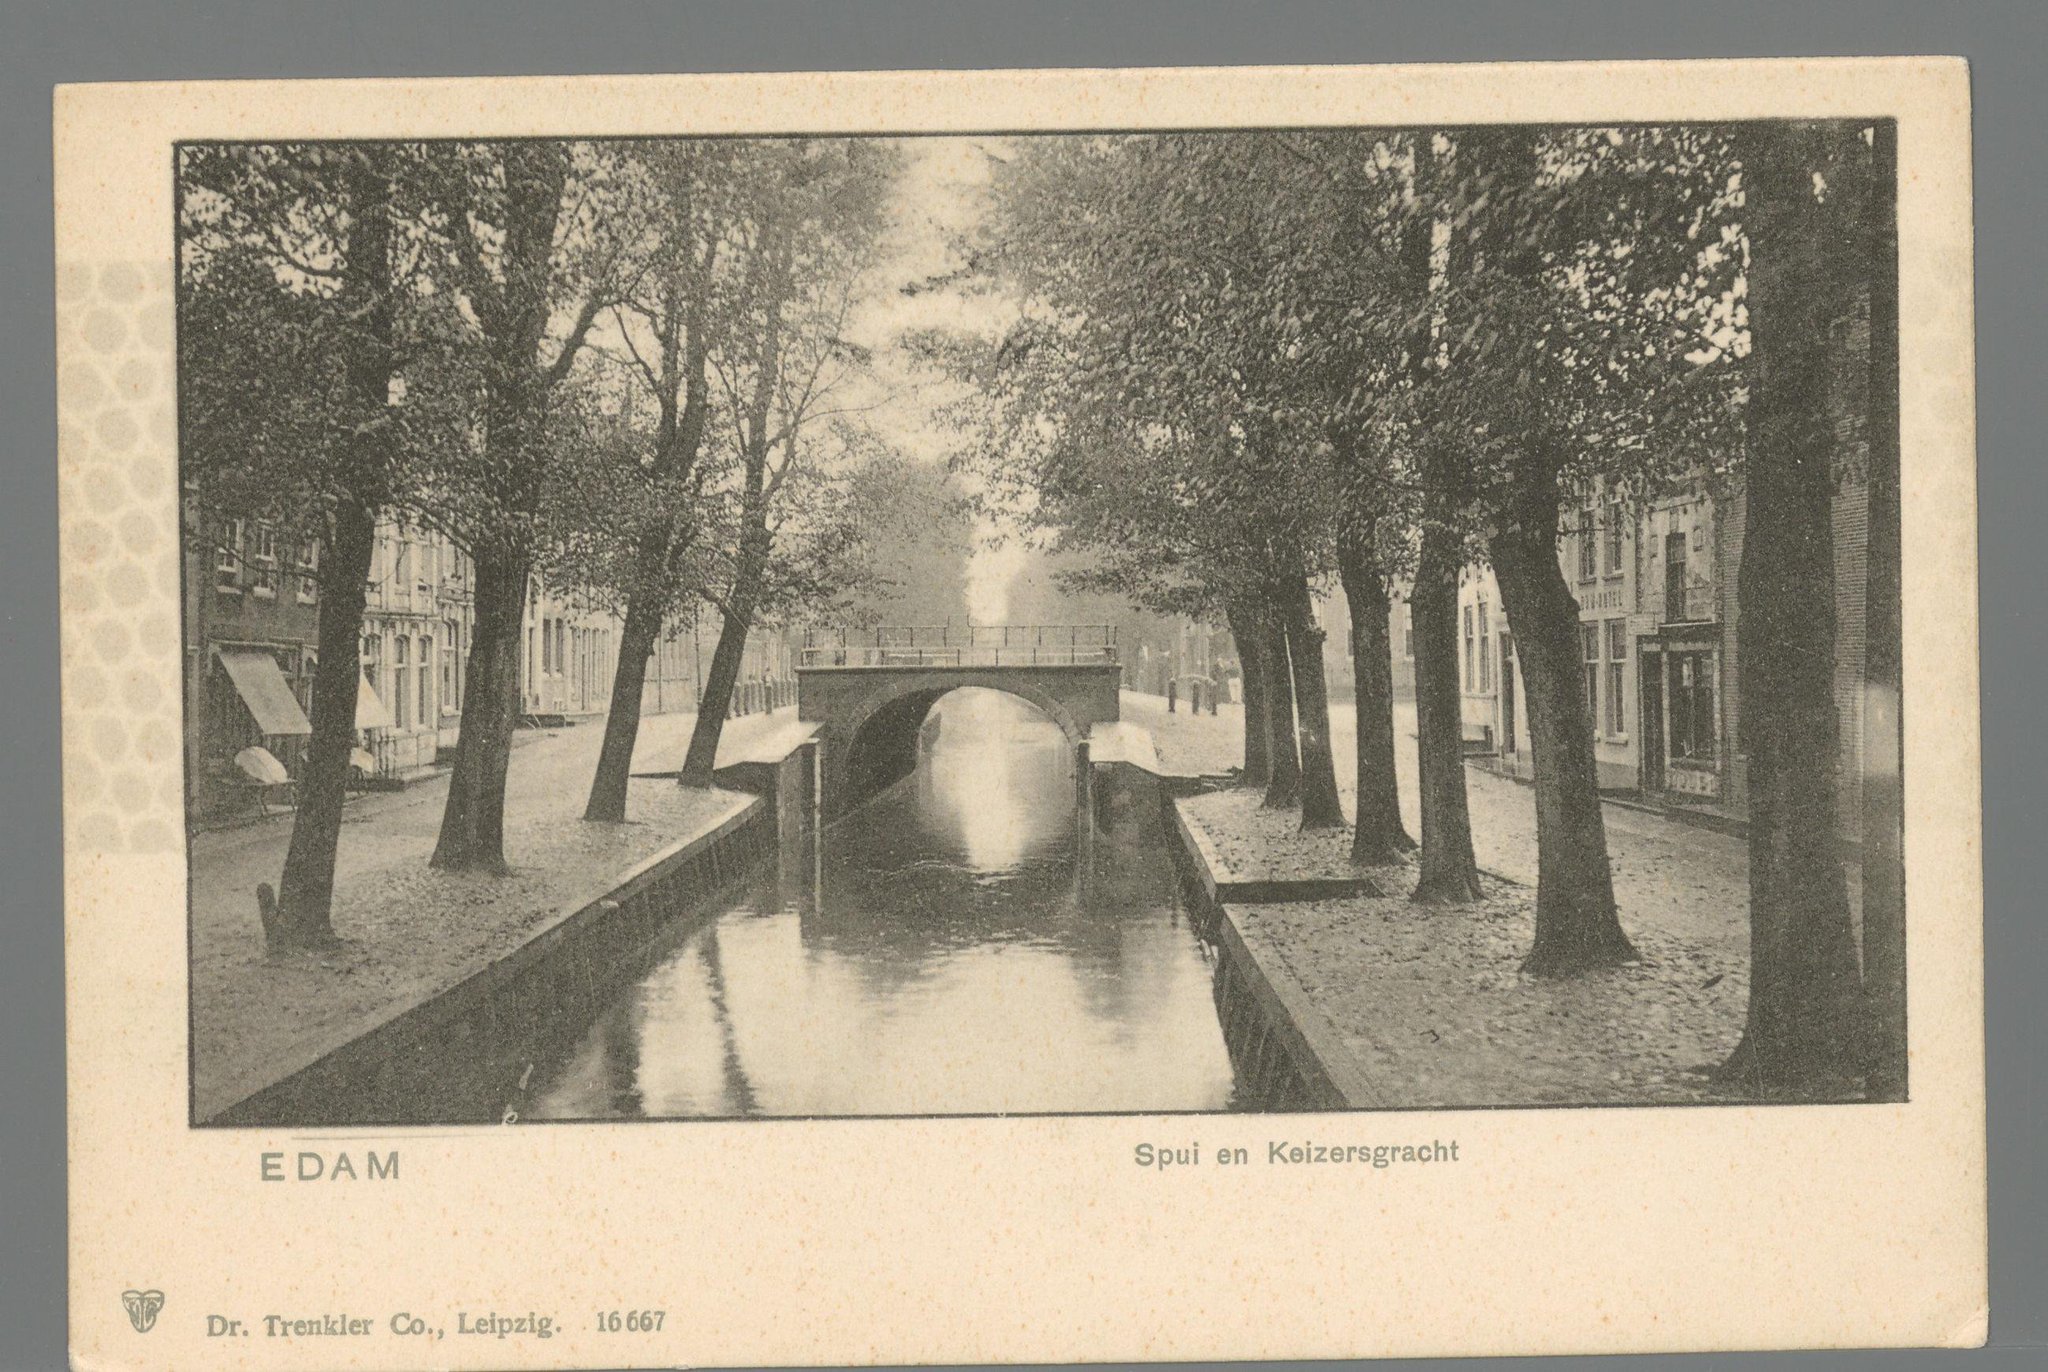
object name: ansichtkaart, prentbriefkaart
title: Edam. Spui en Keizersgracht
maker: Anonymous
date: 1892-1905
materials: cardboard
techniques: photograph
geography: leipzig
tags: canals, waters (in city), bridge in city across river, canal, etc., street